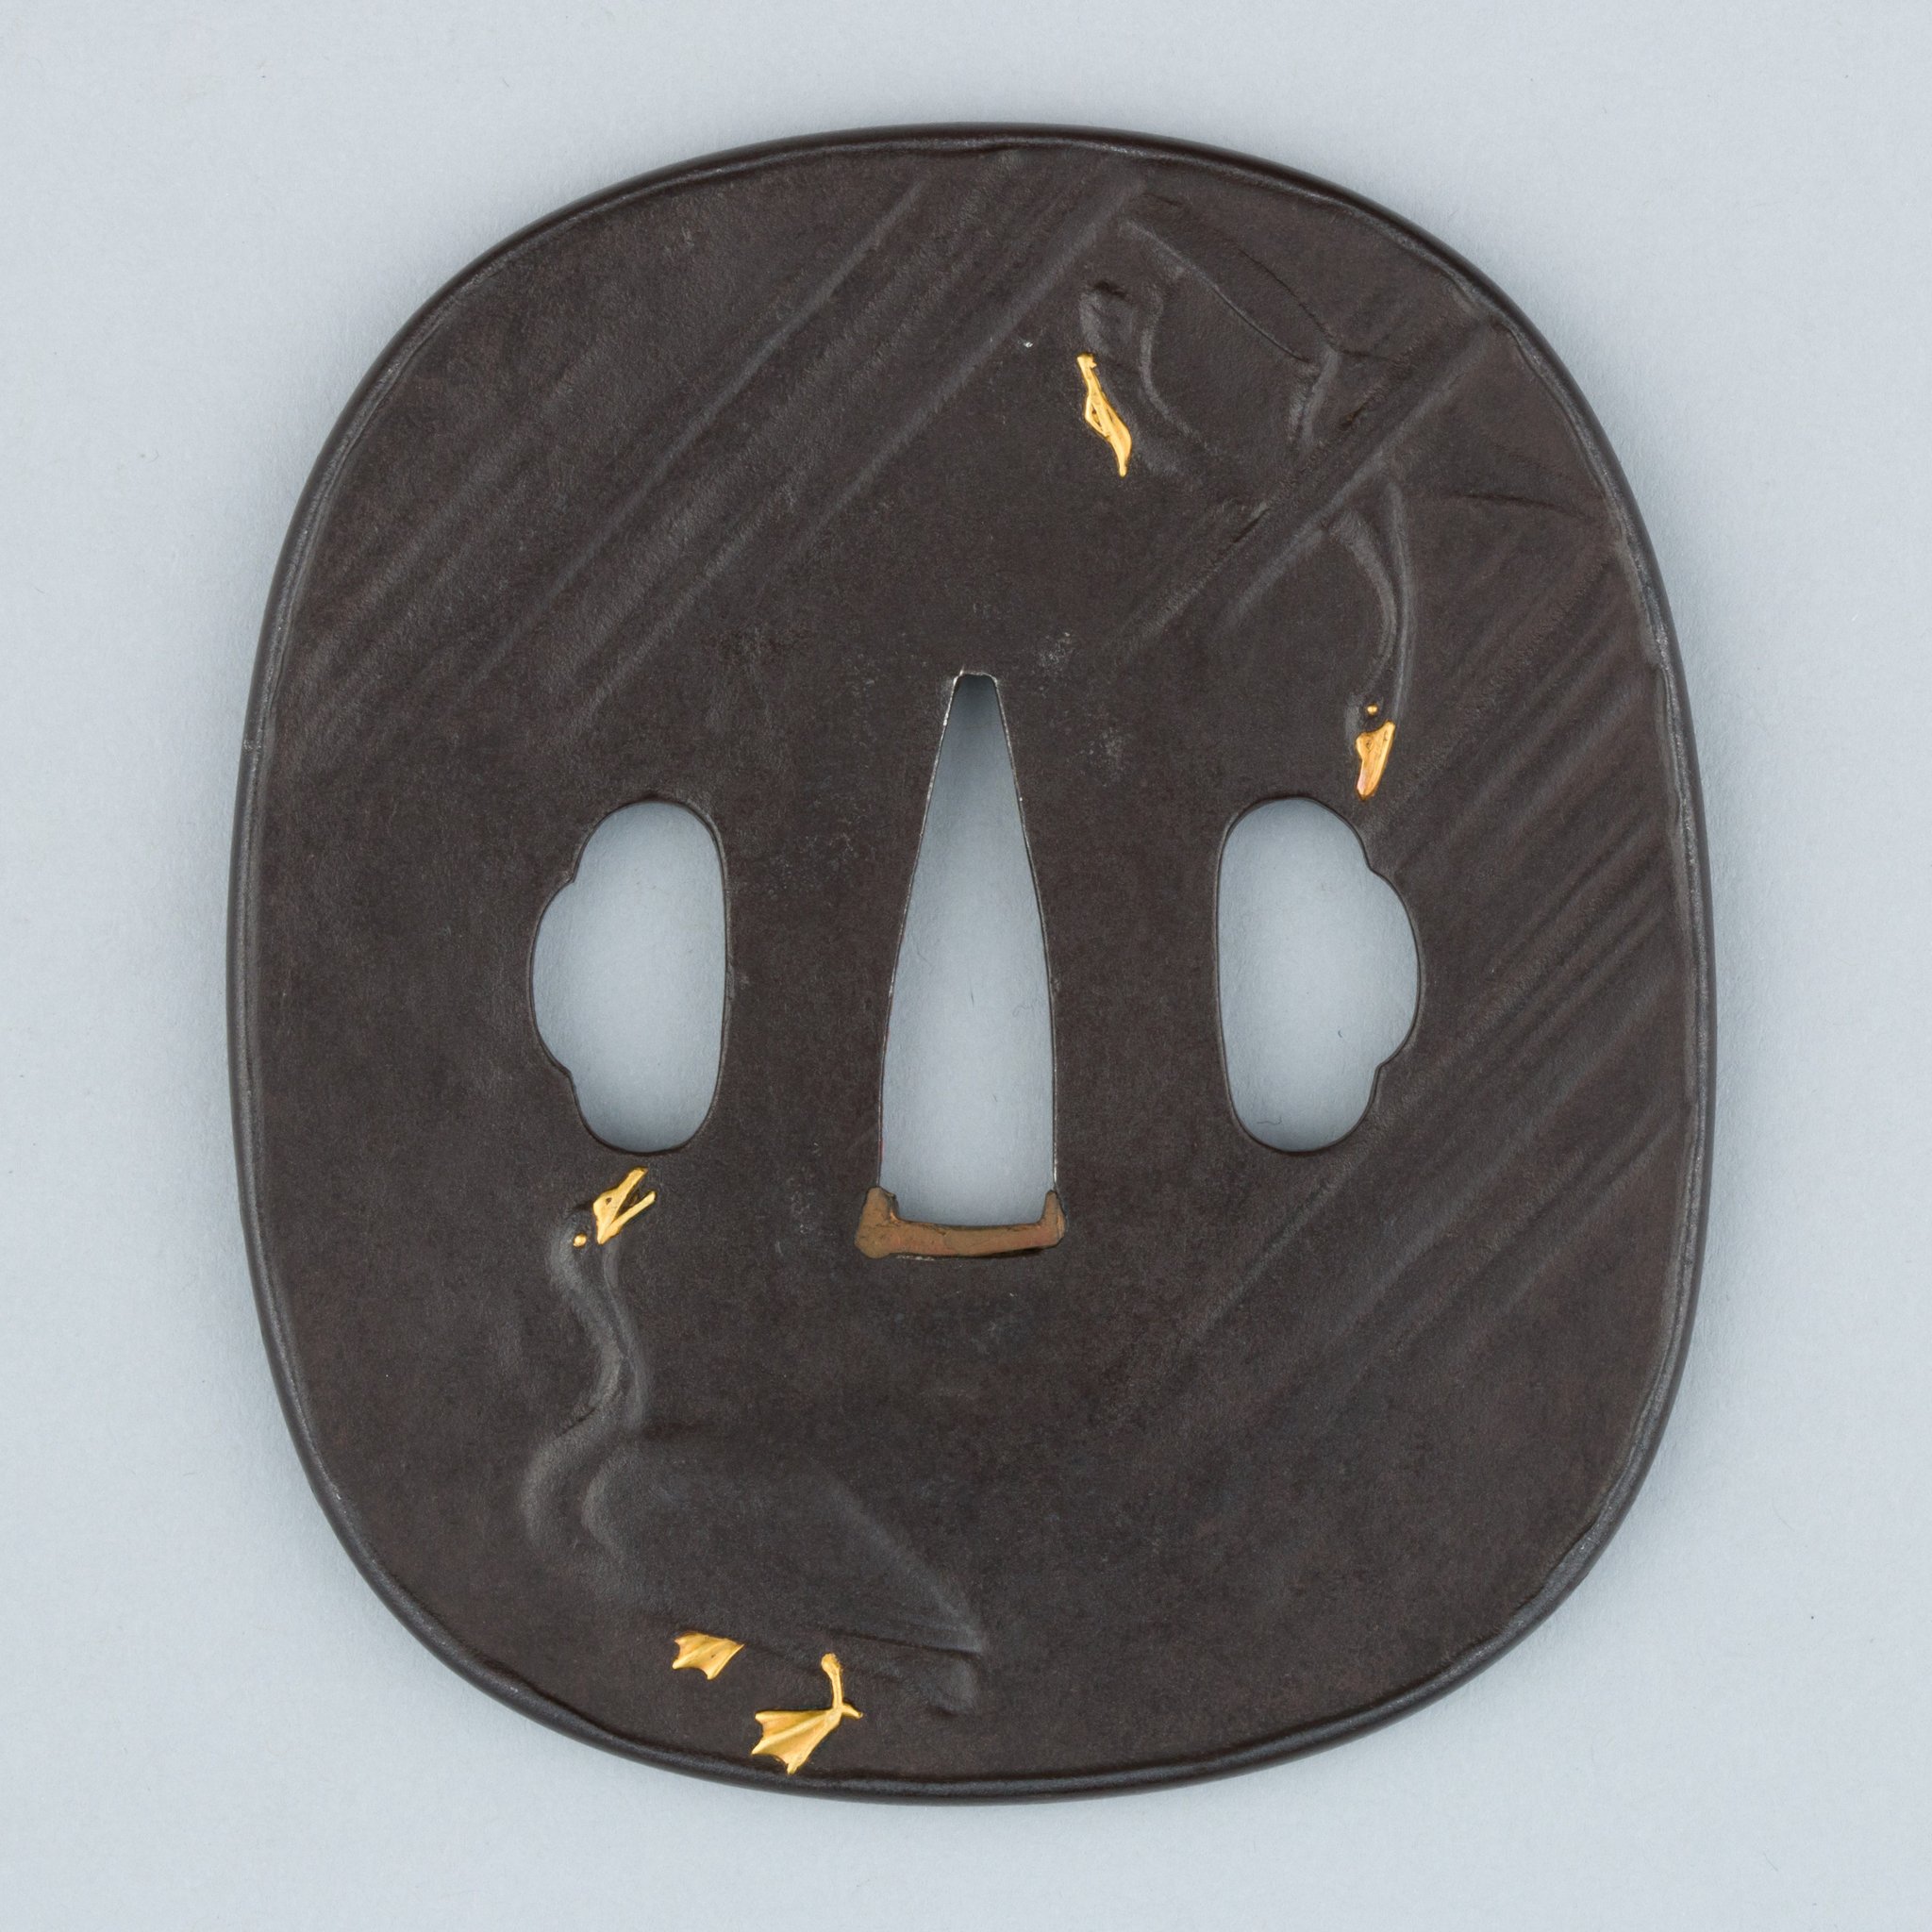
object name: sword guard tsuba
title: Sword Guard (Tsuba)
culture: japanese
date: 1860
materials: copper, gold, iron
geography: japan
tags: ducks